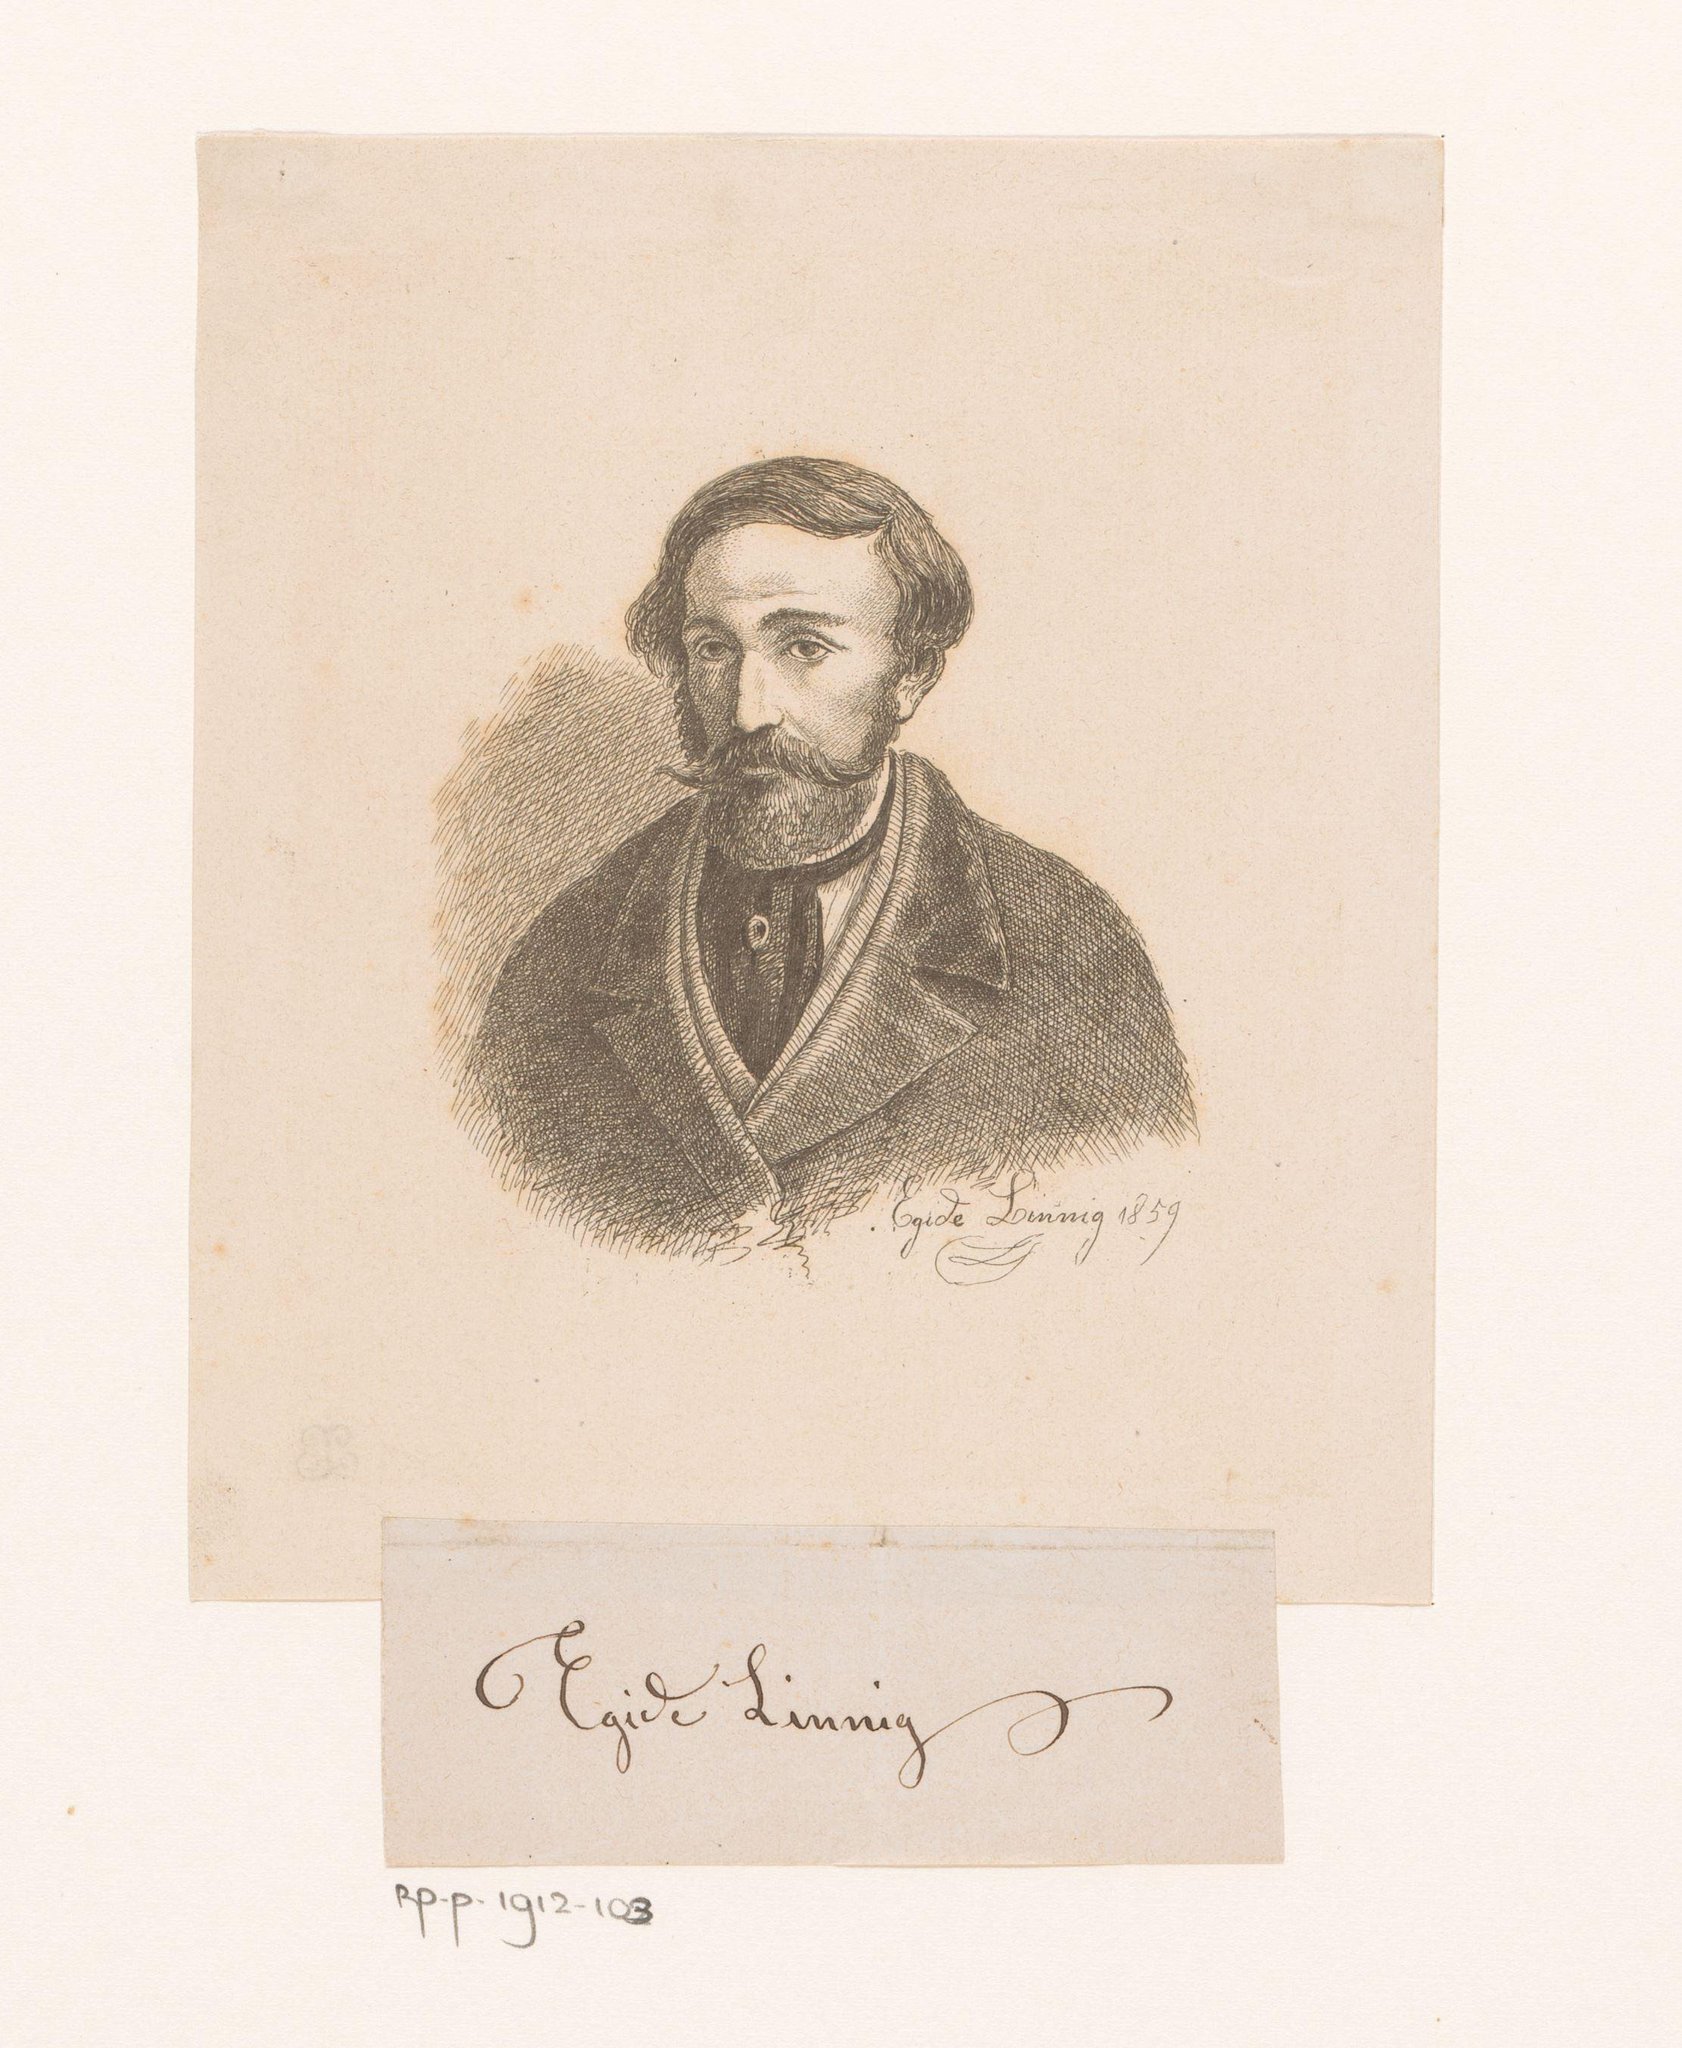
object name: print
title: Zelfportret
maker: egidius linnig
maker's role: draughtsman, print maker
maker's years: 1821-1860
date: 1859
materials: paper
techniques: printmaking, etching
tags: antwerp, print maker, egidius linnig, portrait, self-portrait of artist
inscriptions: collector's mark: Lugt 1485, collector's mark: Lugt 2228